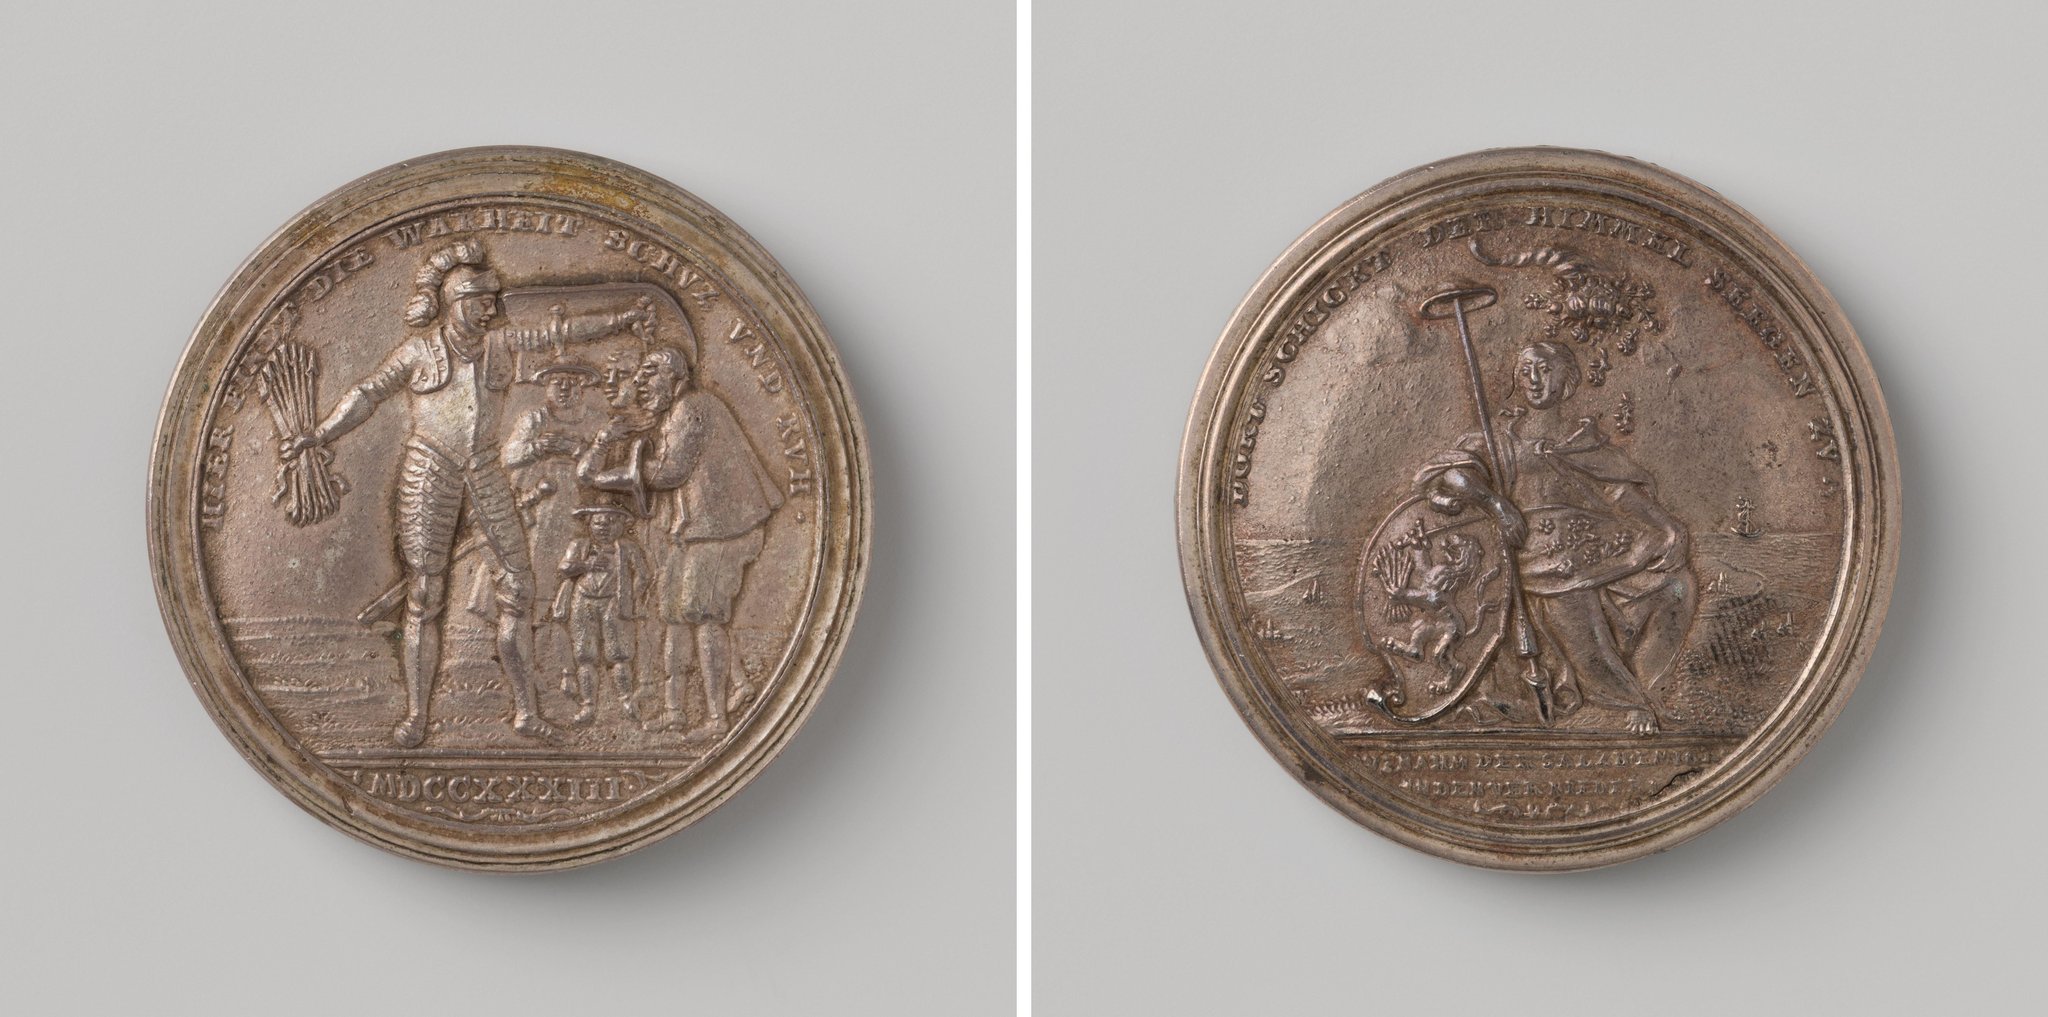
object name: box taler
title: Opname der Salzburger emigranten in Nederland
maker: abraham remshard (i)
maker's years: 1679-1754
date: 1733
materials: silver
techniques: striking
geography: augsburg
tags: netherlands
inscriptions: circumscription: ‘HIER FINDT DIE WARHEIT SCHVZ VND RVH’, date: ‘MDCCXXXIII.’, caption: ‘AVFNAHM DER SALZB. EMIGR./ IN DEM VER. NIEDERL.’, circumscription: ‘DORT SCHICKT DER HIMMEL SEEGEN ZV’